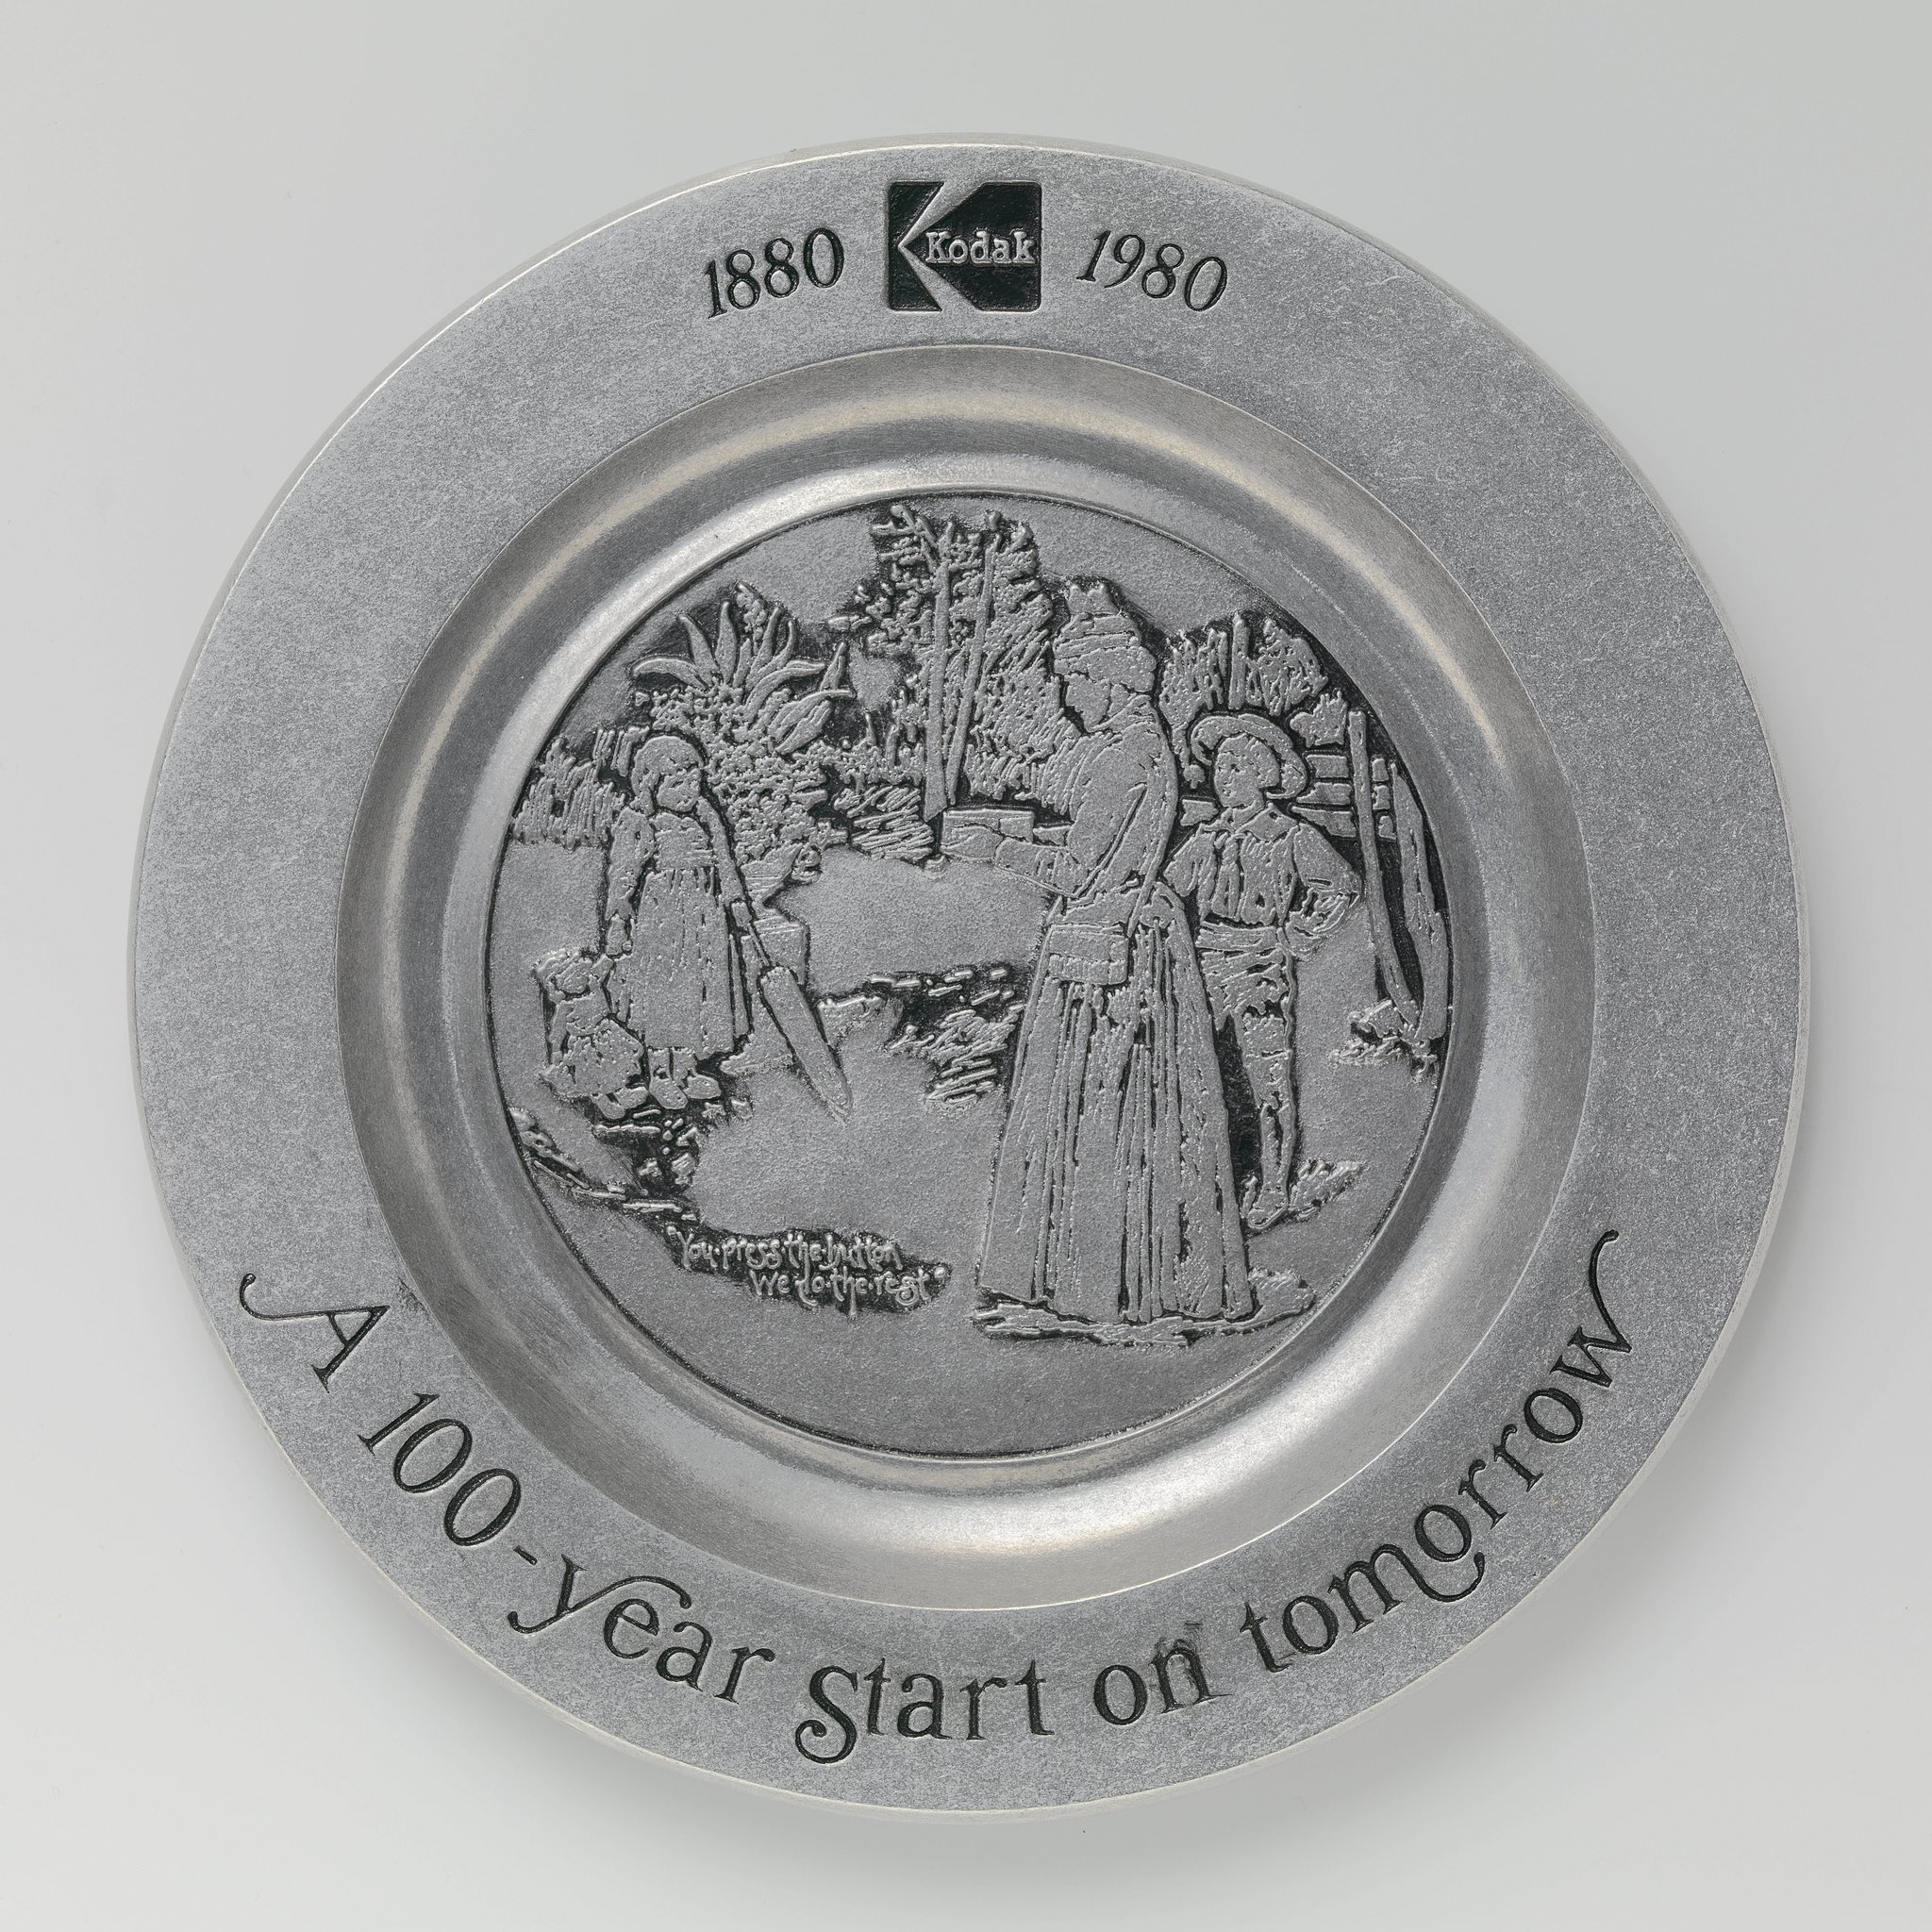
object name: plate dish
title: Kodak 1880-1980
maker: Anonymous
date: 1980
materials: metal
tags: taking photographs - cc - out of doors, garden